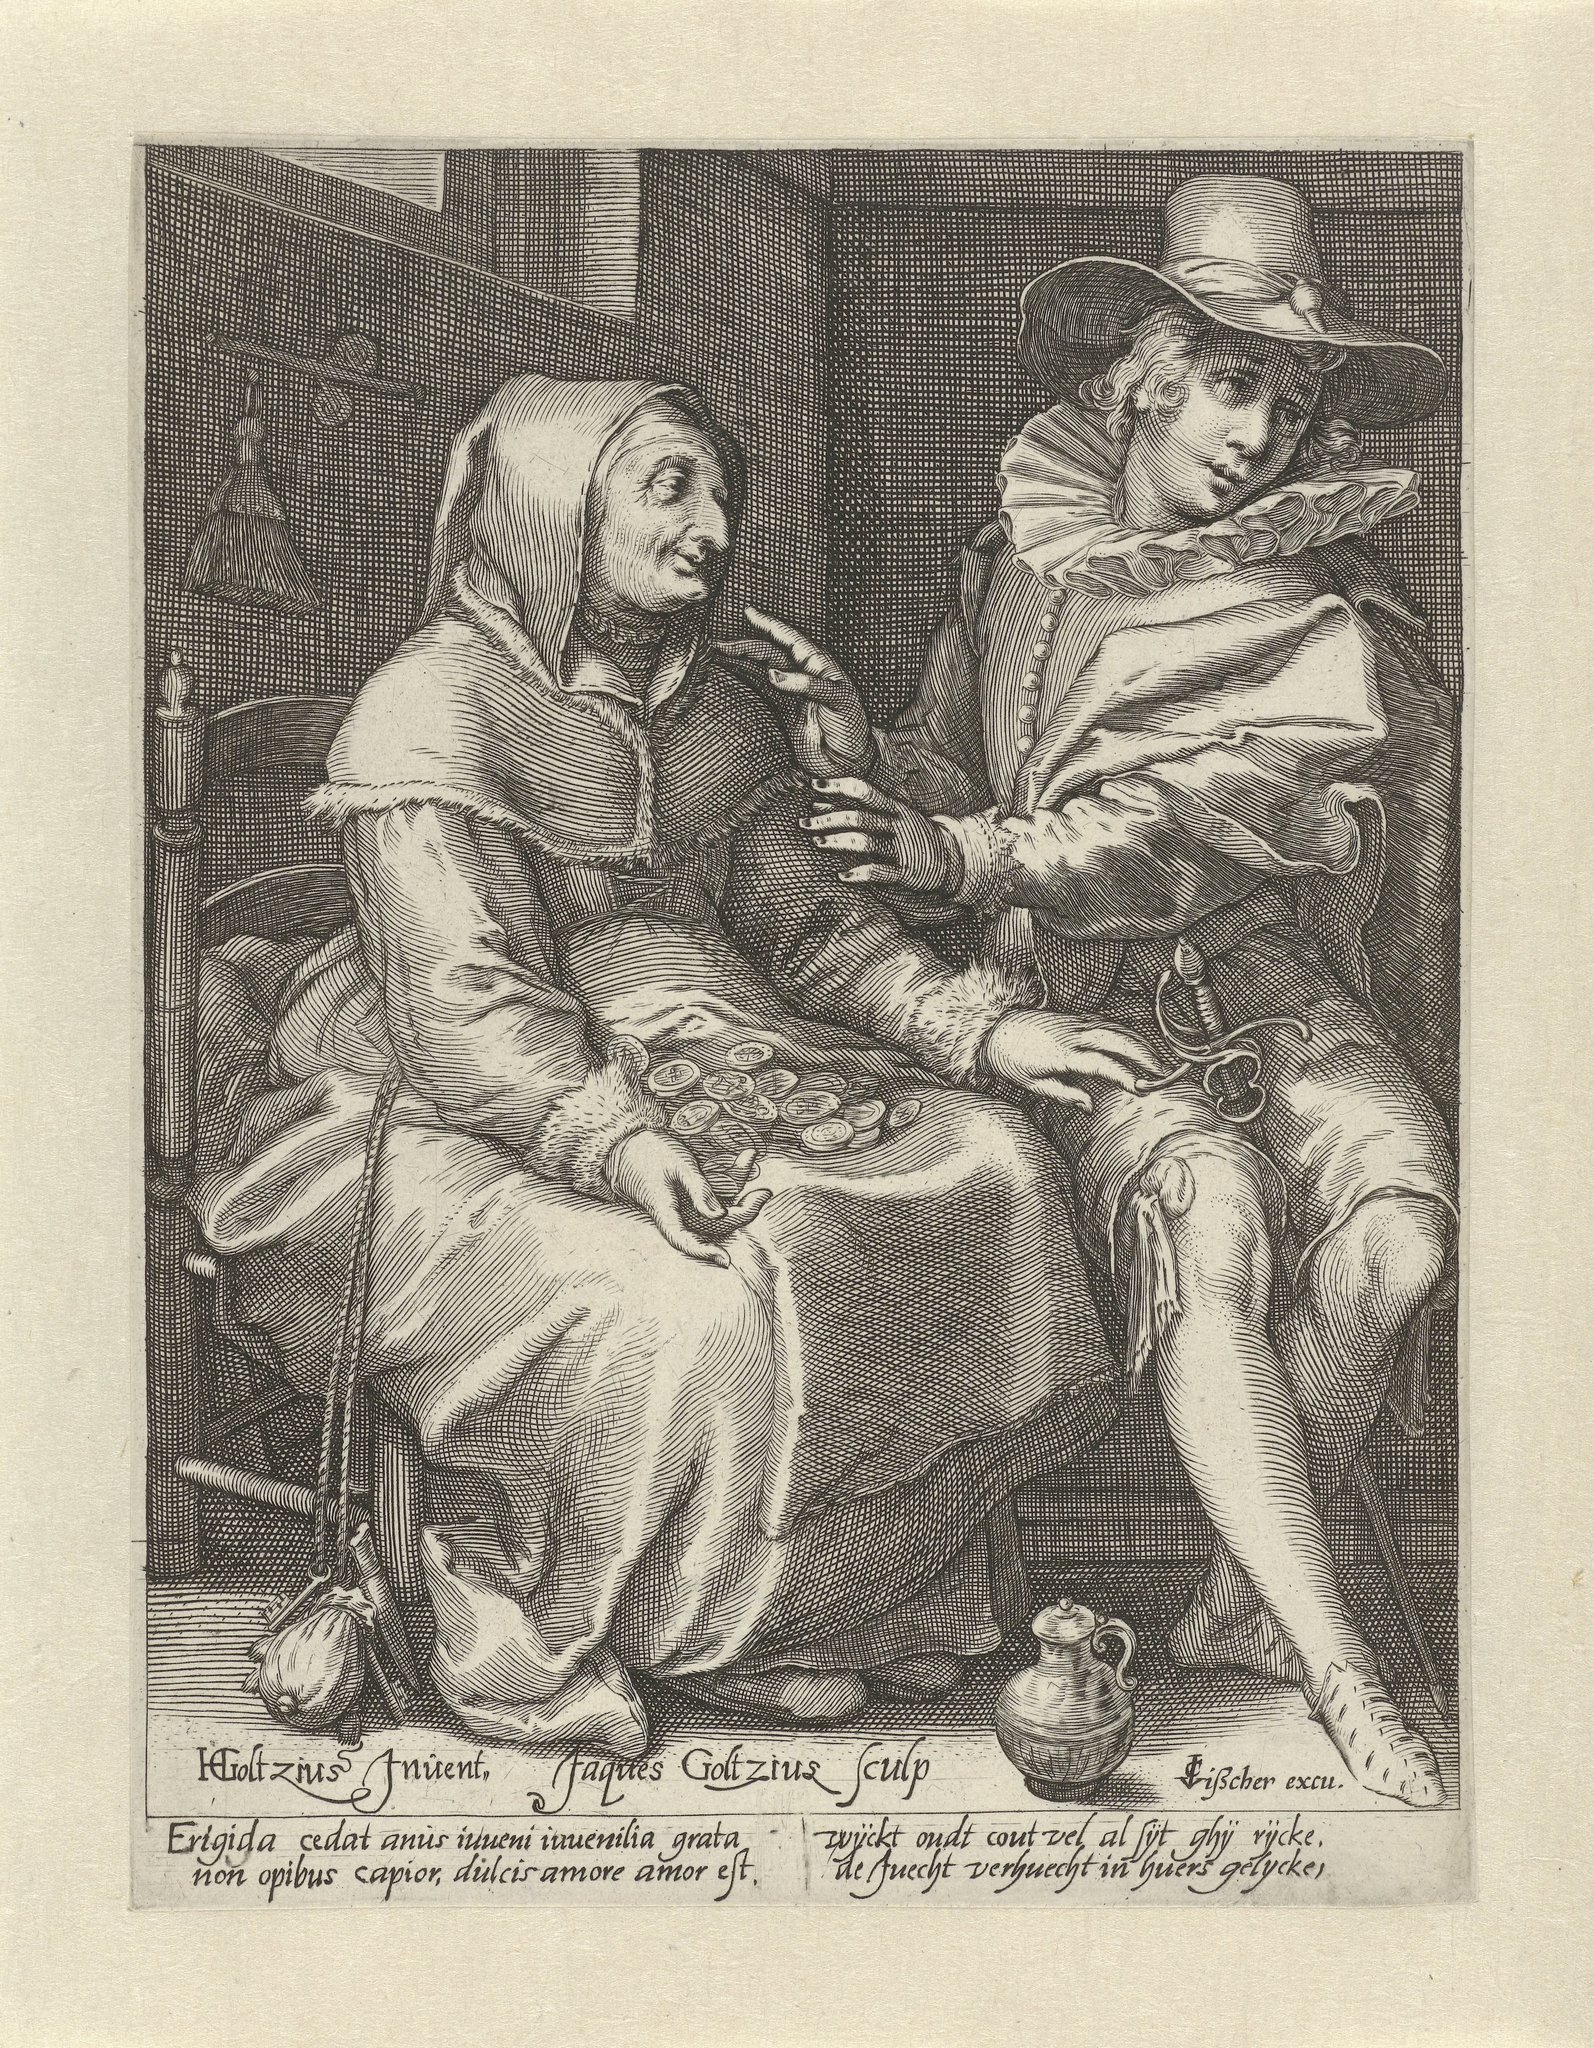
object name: print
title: Ongelijke liefde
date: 1605-1630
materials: paper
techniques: engraving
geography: haarlem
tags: pursuit of a woman, prowling, young versus old age; young and old, ugly old woman, hag, money, married couple of unequal age - dd - woman older, youth, adolescent (+ old male (human being))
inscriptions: collector's mark: Lugt 2228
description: Een oude vrouw zit op een stoel. In haar schoot een aantal munten. Naast haar een jongeman op een stoel. De vrouw legt haar hand op het been van de man, maar hij draait zich weg van haar. De prent heeft een Latijns en Nederlands onderschrift